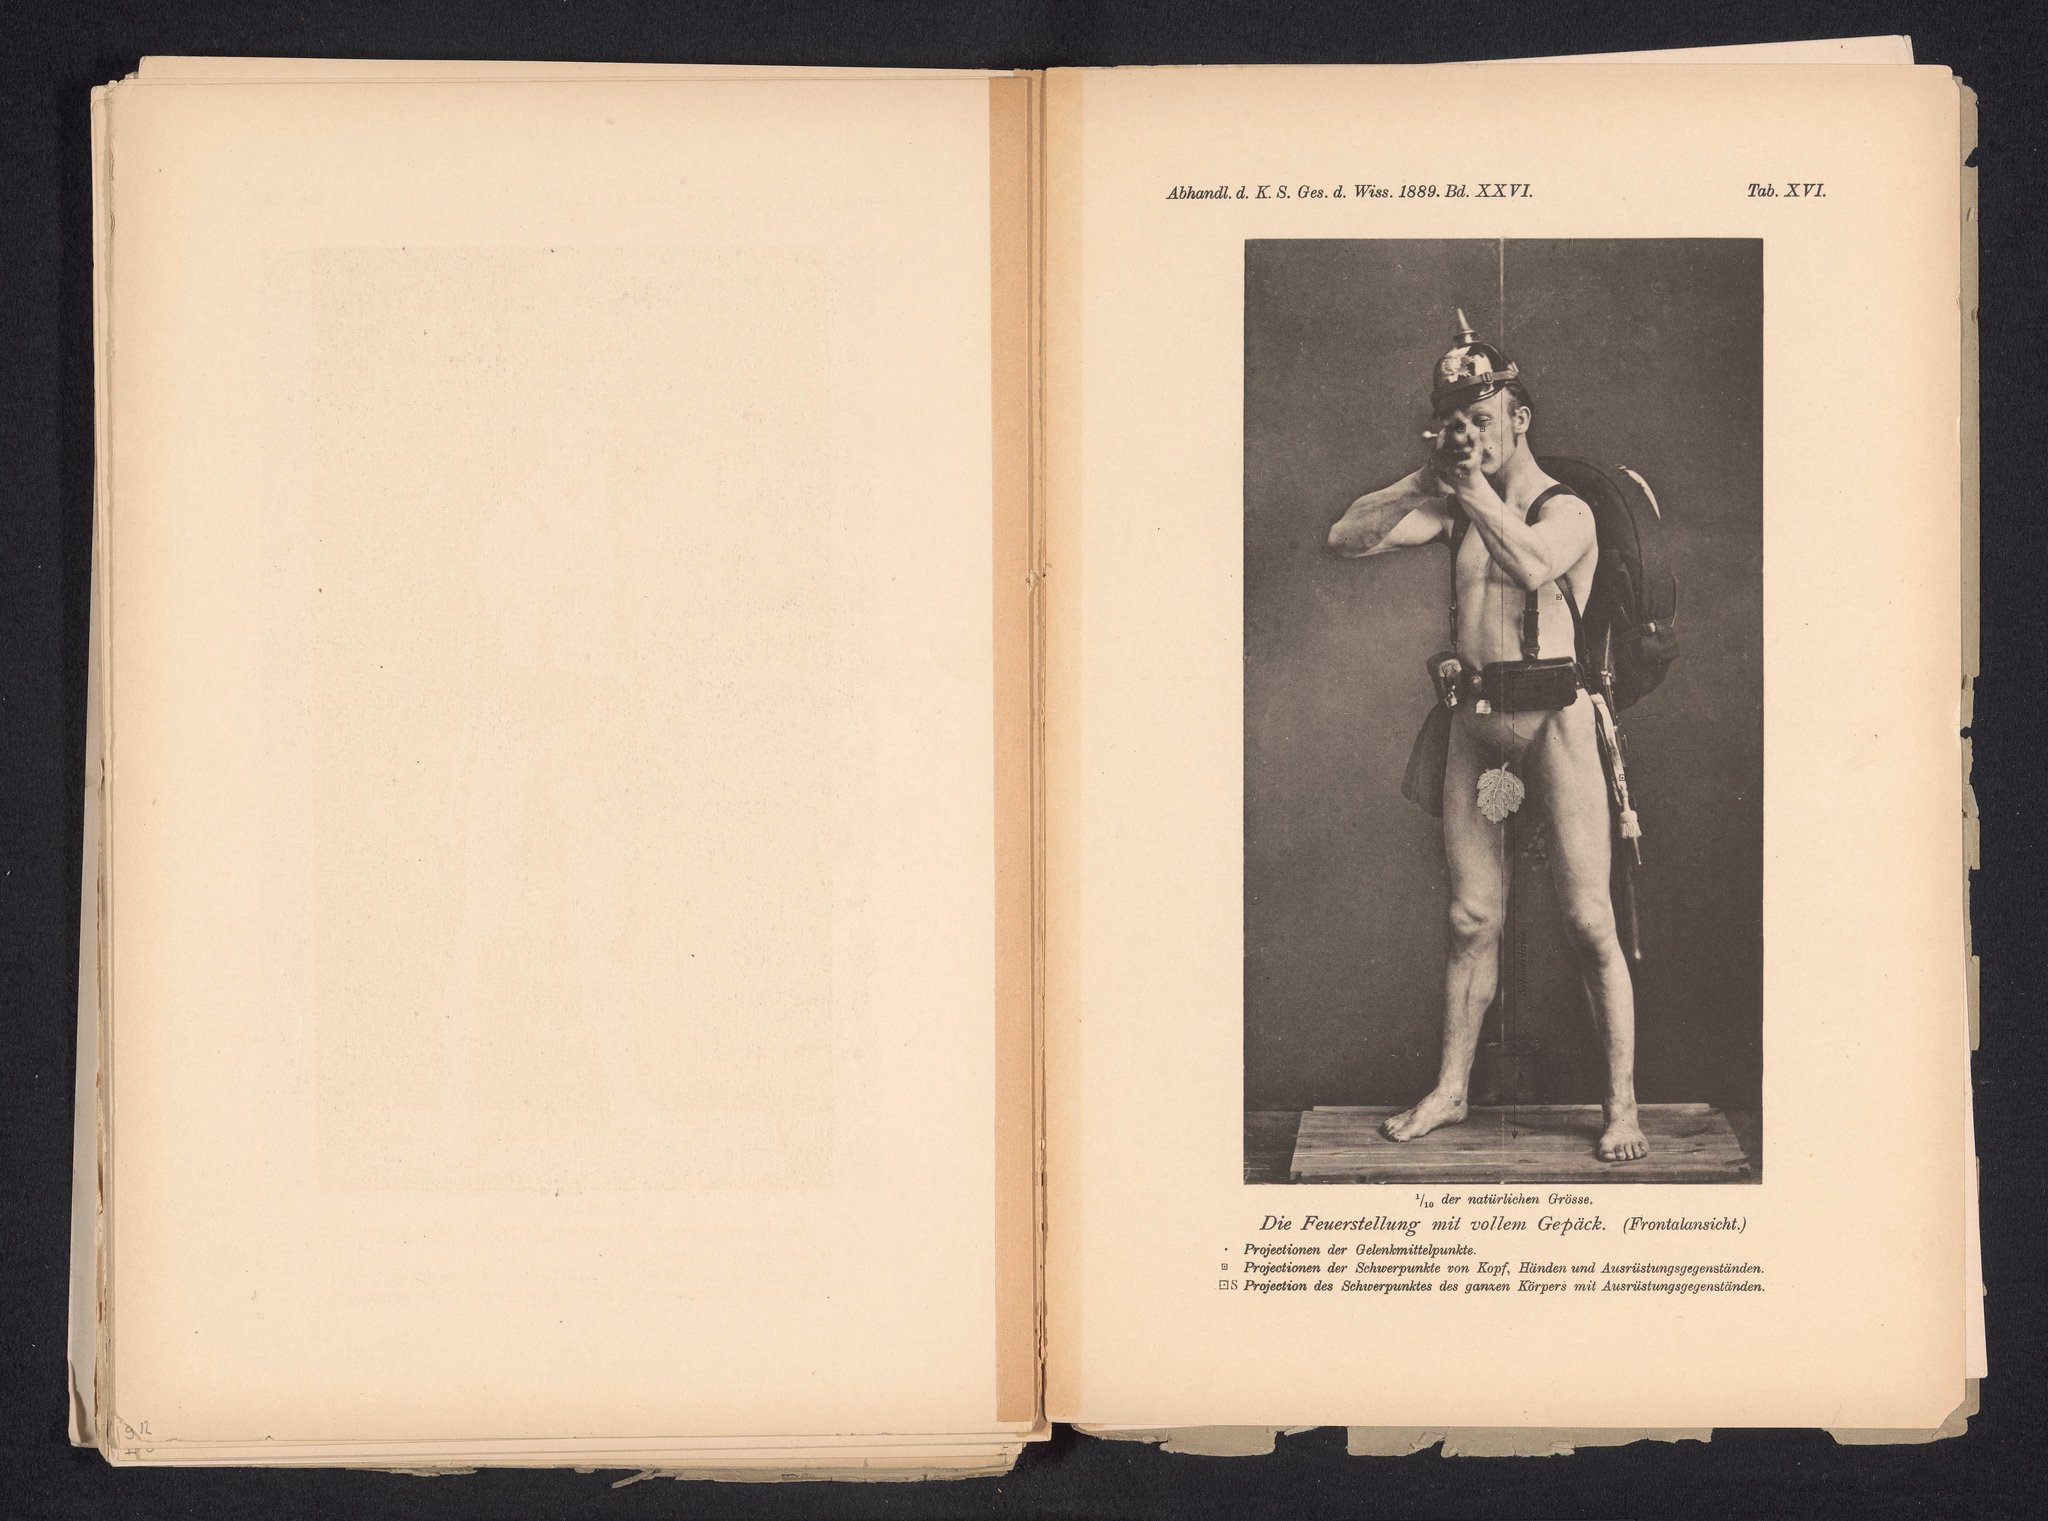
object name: page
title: Die Feuerstellung mit vollem Gepäck. (Frontalansicht)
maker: Anonymous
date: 1880-1890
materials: paper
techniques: photograph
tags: anatomy (non-medical), firearms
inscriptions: number: ‘Tab. XVI.’, inscription: ‘Schwerlinie. 1/10 der natürlichen Grösse. Projectionen der Gelenkmittelpunkte. Projectionen der Schwerpunkte von Kopf, Händen und Ausrüstungsgegenständen. Projection des Schwerpunkte des ganzen Körpers mit Ausrüstungsgegenständen.’